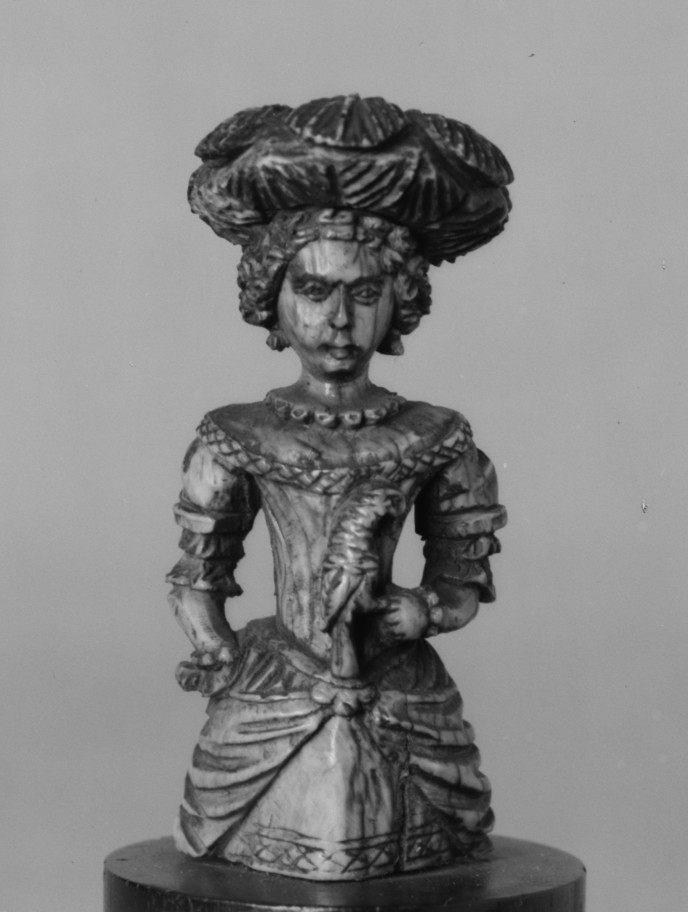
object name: statuette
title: Woman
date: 1601-1700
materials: ivory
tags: women